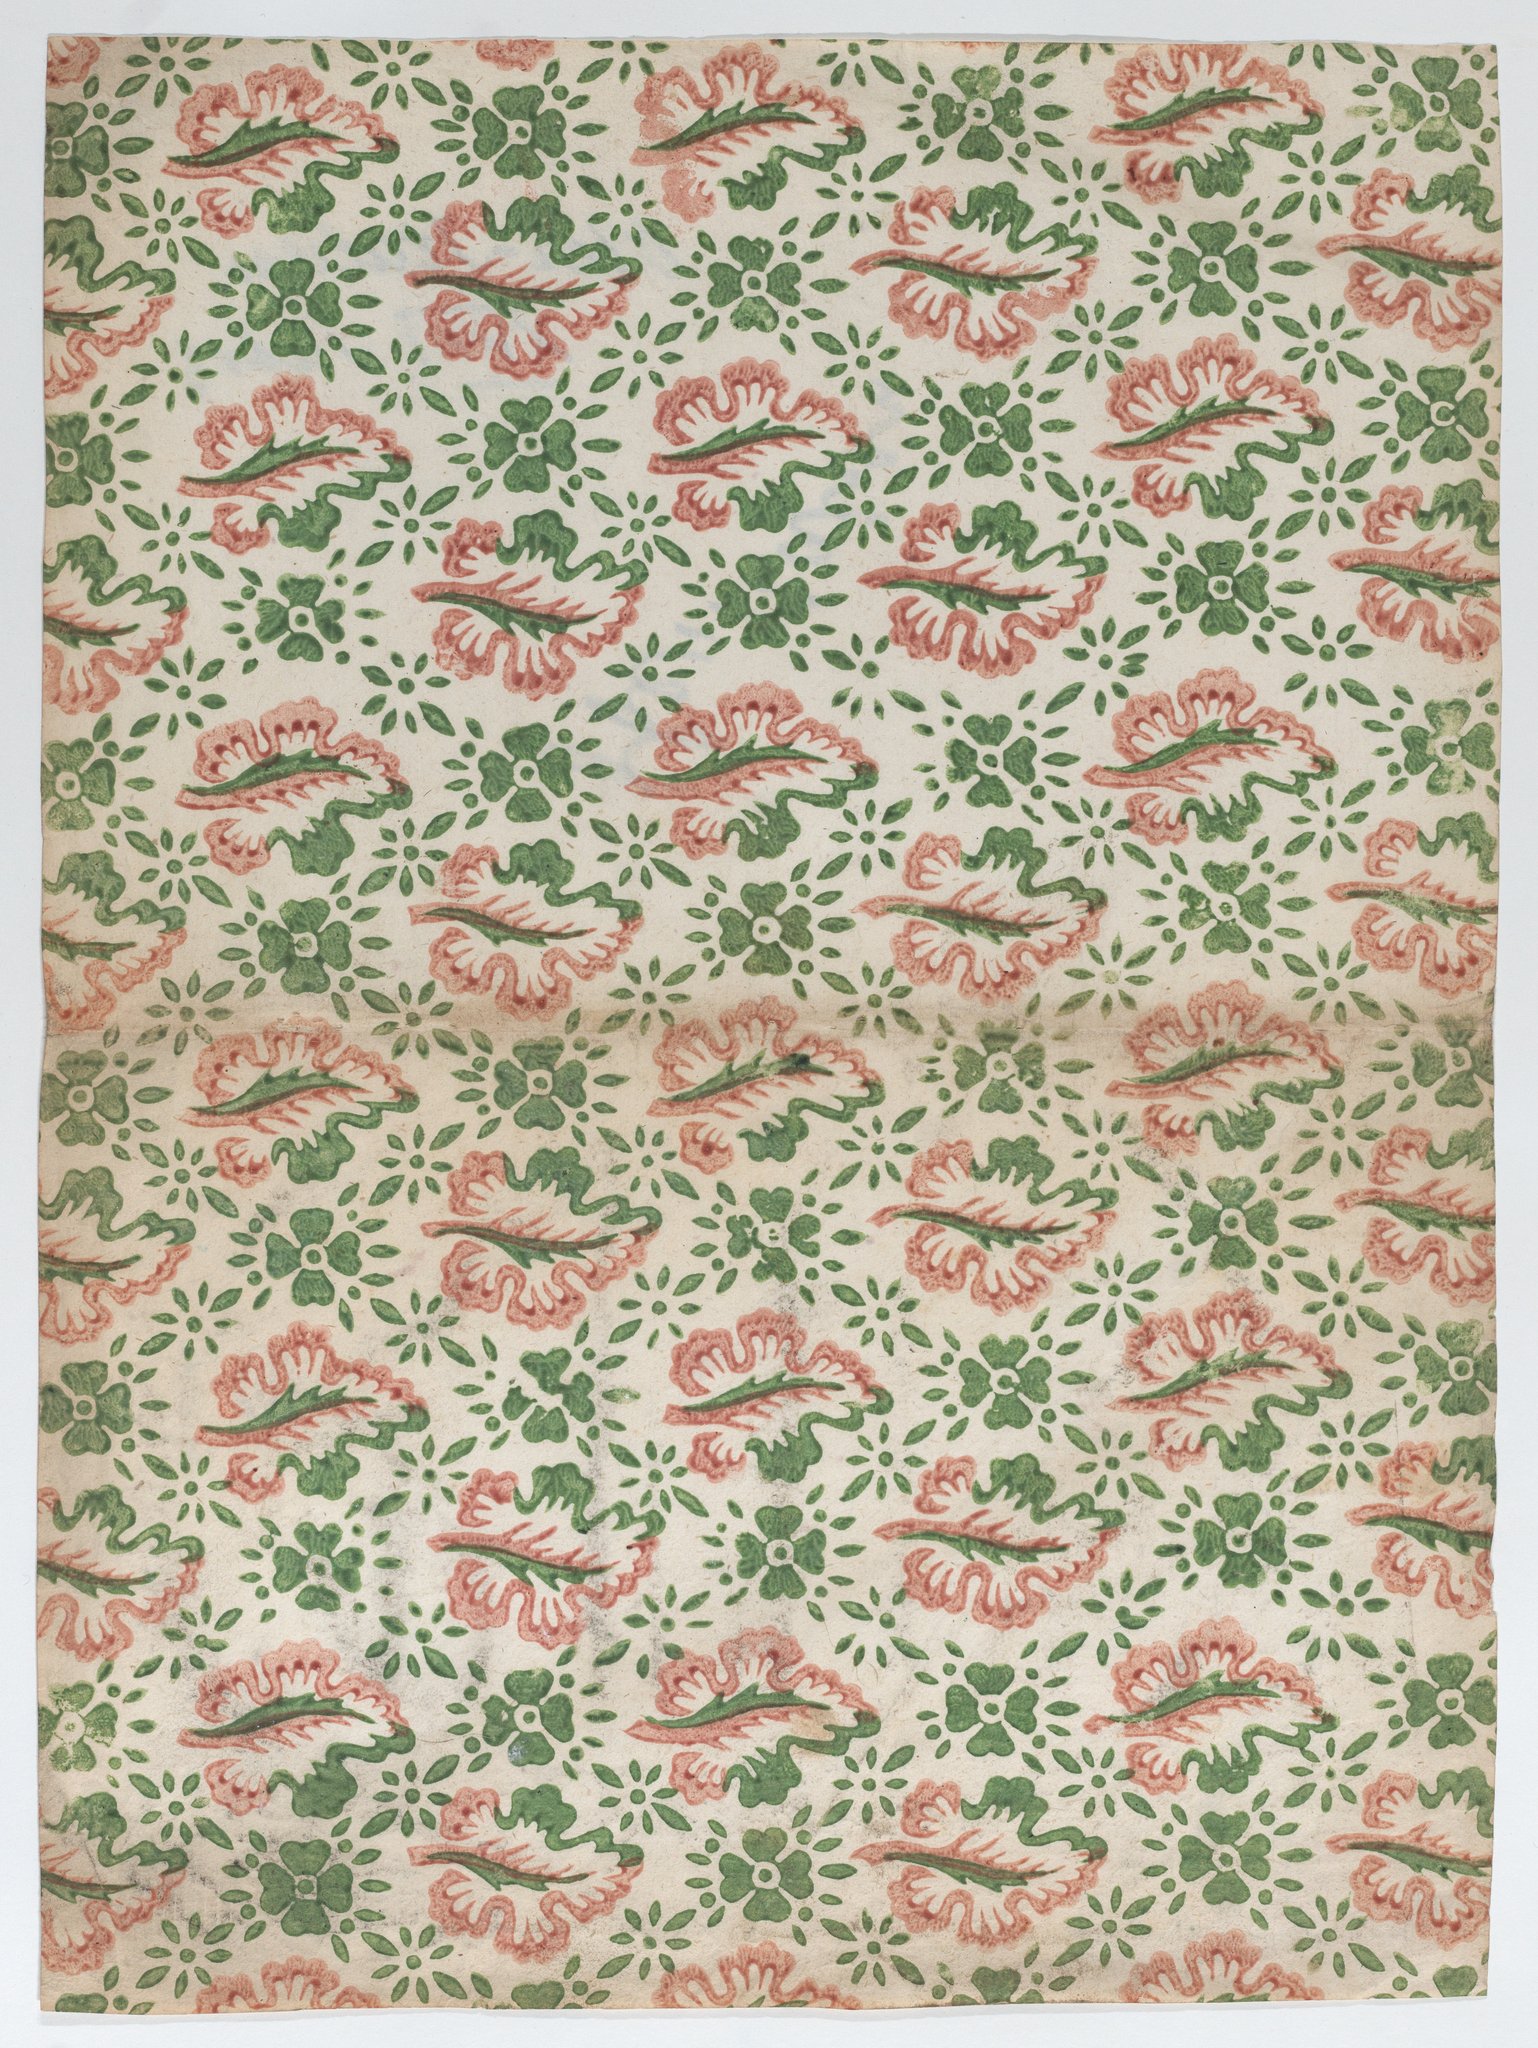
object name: print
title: Sheet with overall red and green floral pattern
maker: Anonymous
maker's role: artist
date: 1701-1800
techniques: relief print